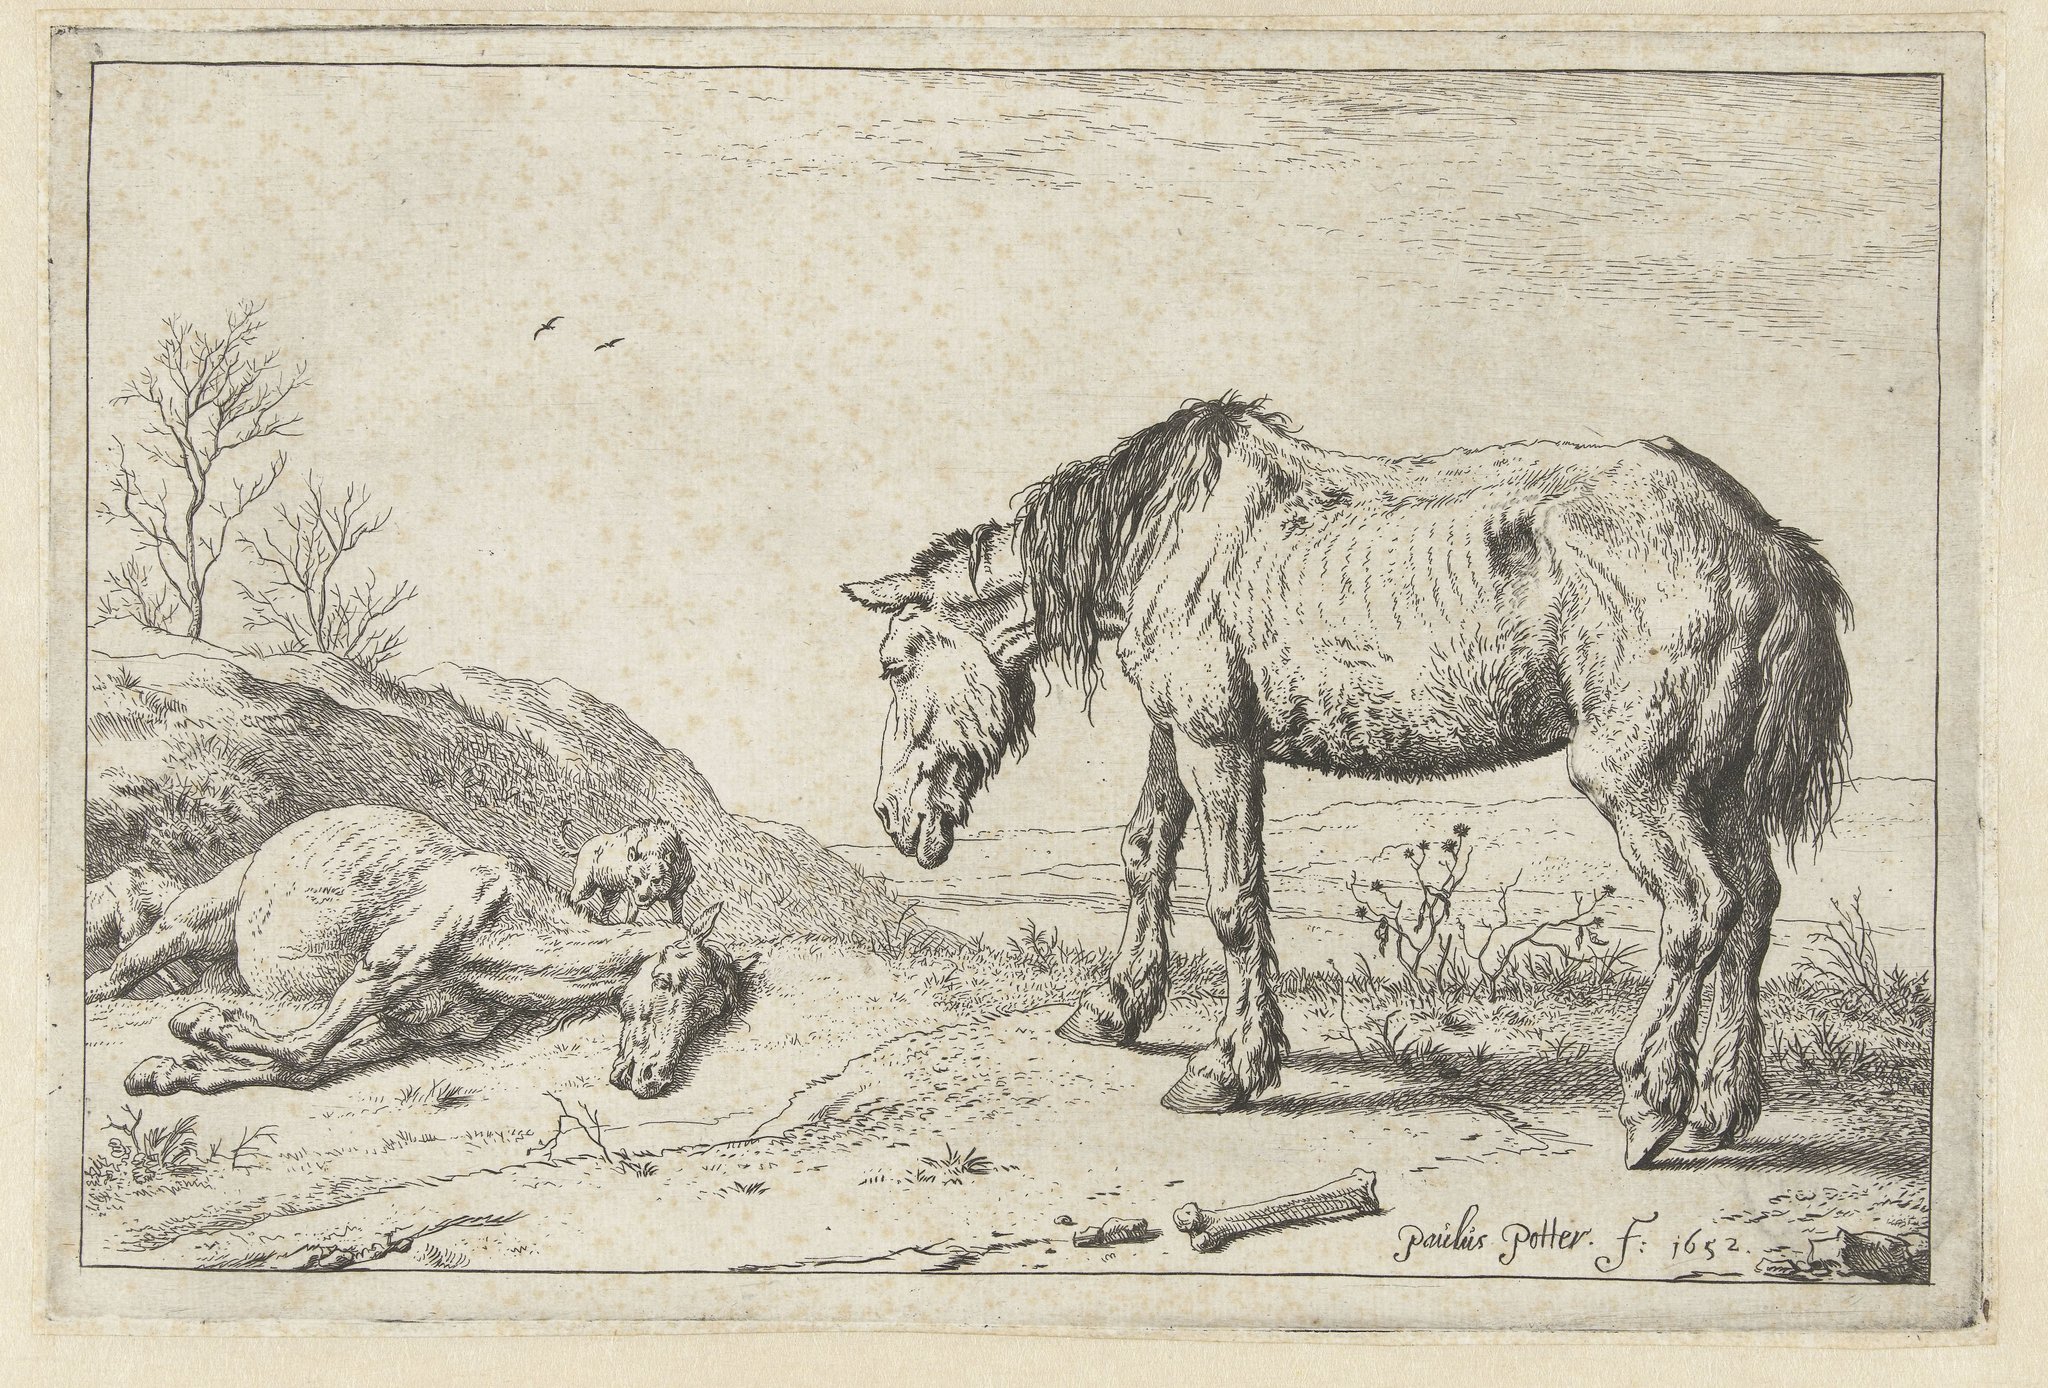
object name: print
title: Sater met kind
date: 1640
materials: paper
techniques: engraving, etching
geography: france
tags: personification of the evening, 'vesper', child, satyr(s) (in general)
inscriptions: number: ‘24’, collector's mark: ‘Hinloopen’, collector's mark: Lugt 11